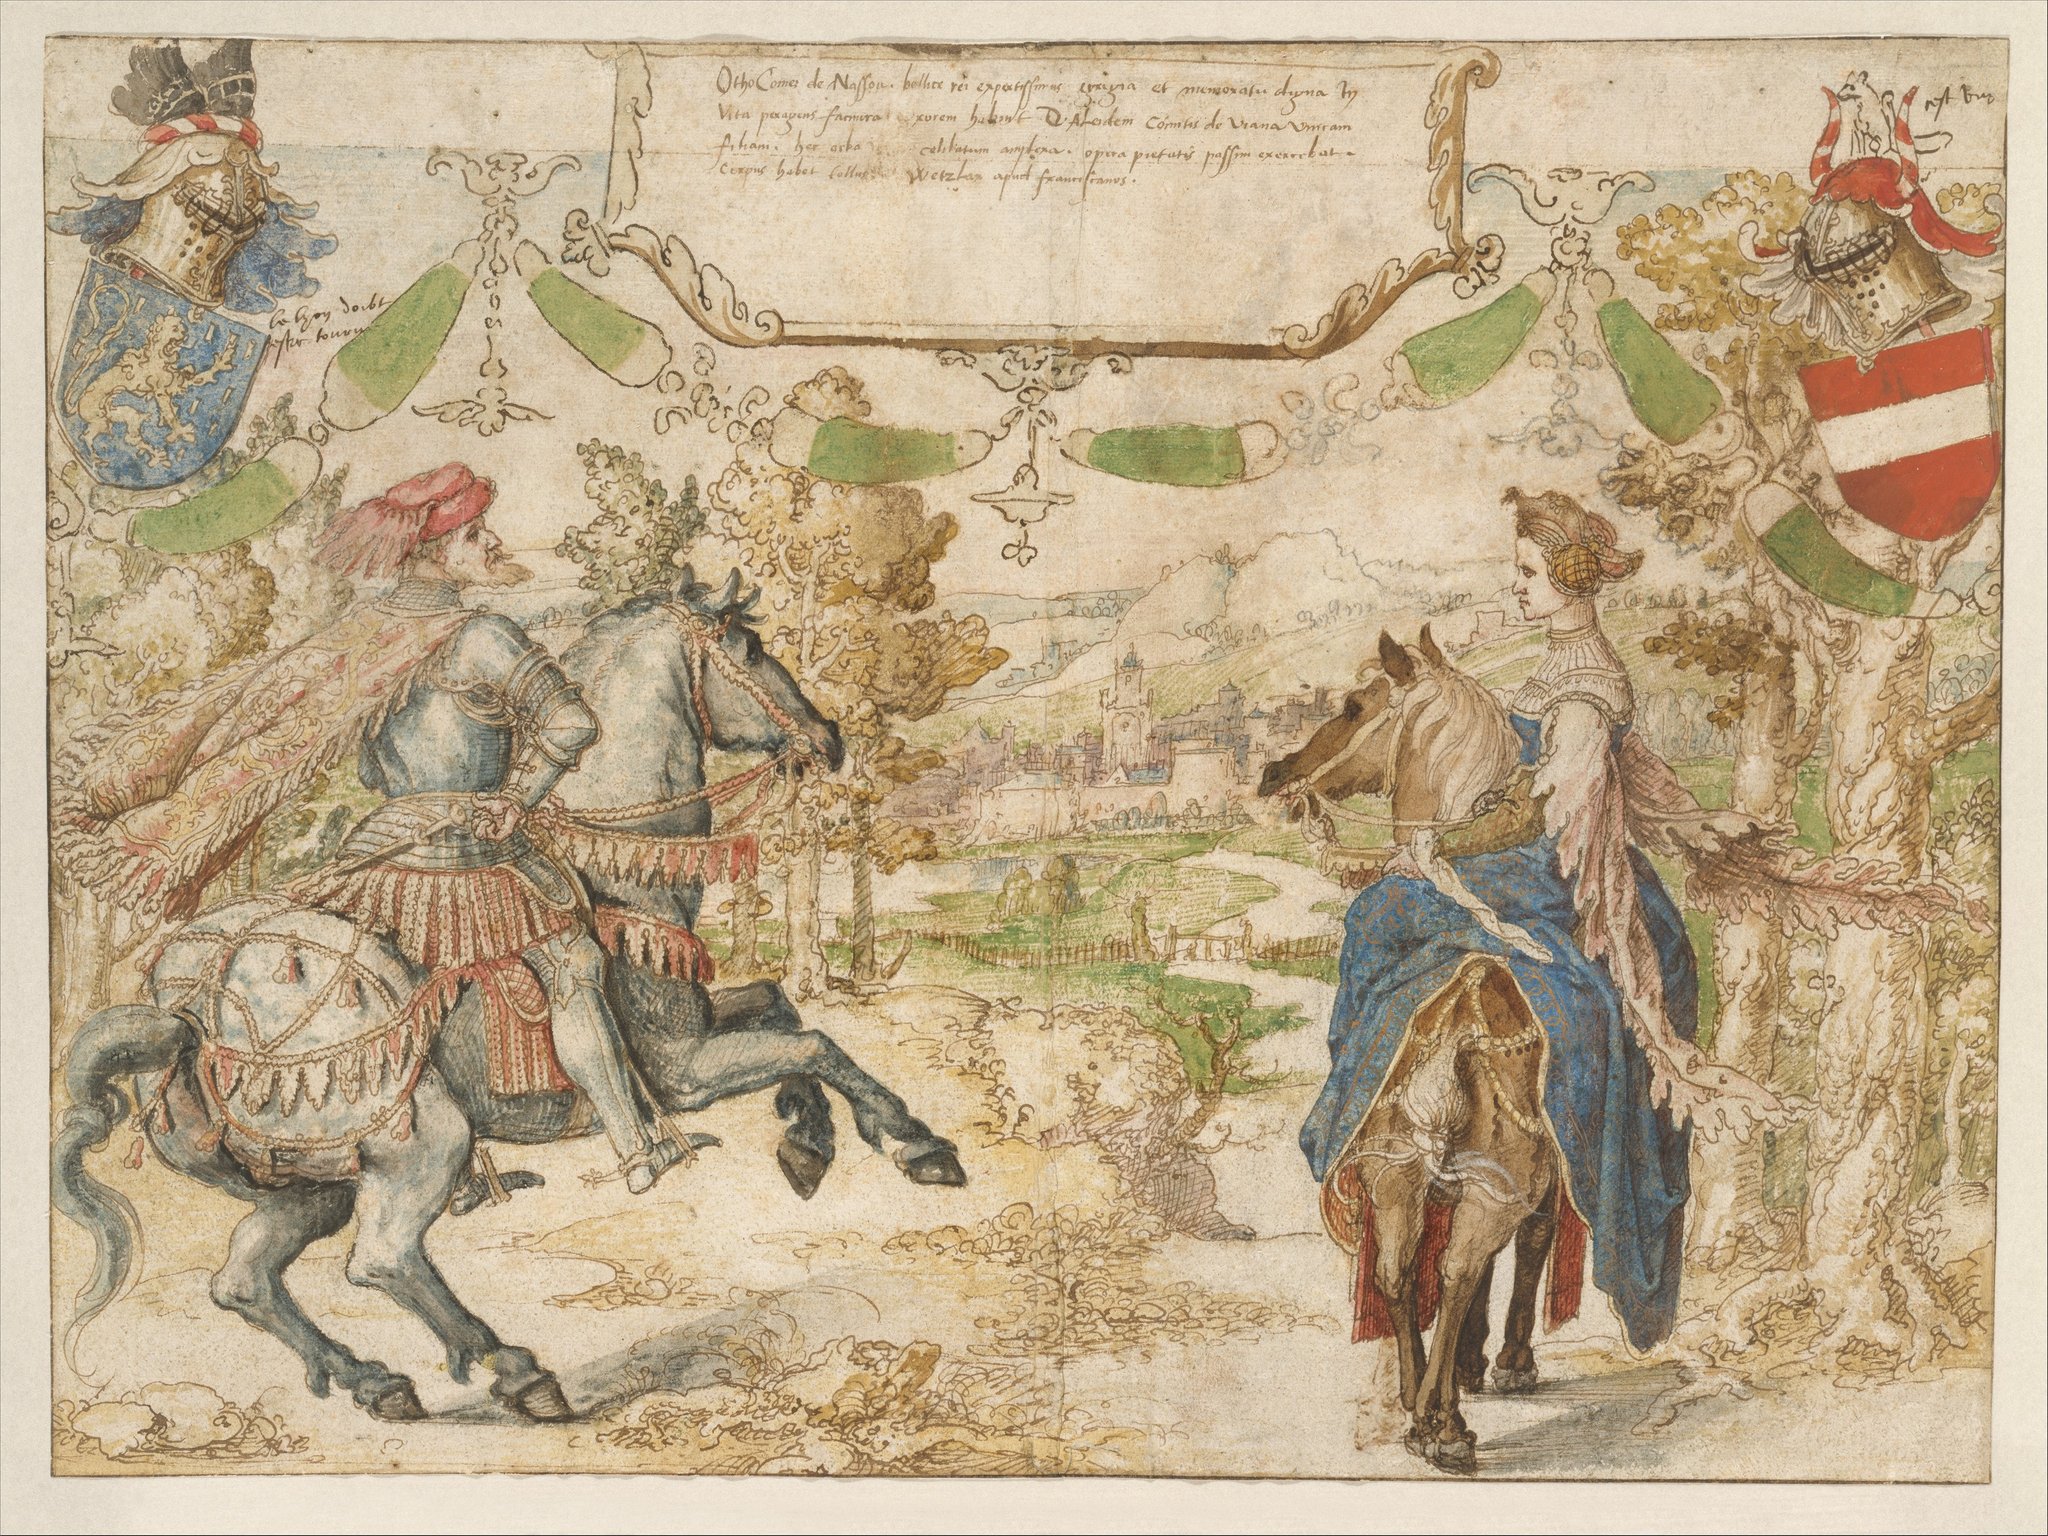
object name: drawing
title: Otto, Count of Nassau and his Wife Adelheid van Vianen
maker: bernard van orley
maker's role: artist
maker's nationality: netherlandish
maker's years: 1492-1542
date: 1530-1535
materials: chalk, ink, watercolor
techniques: pen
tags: men,women,horses,landscapes,coat of arms